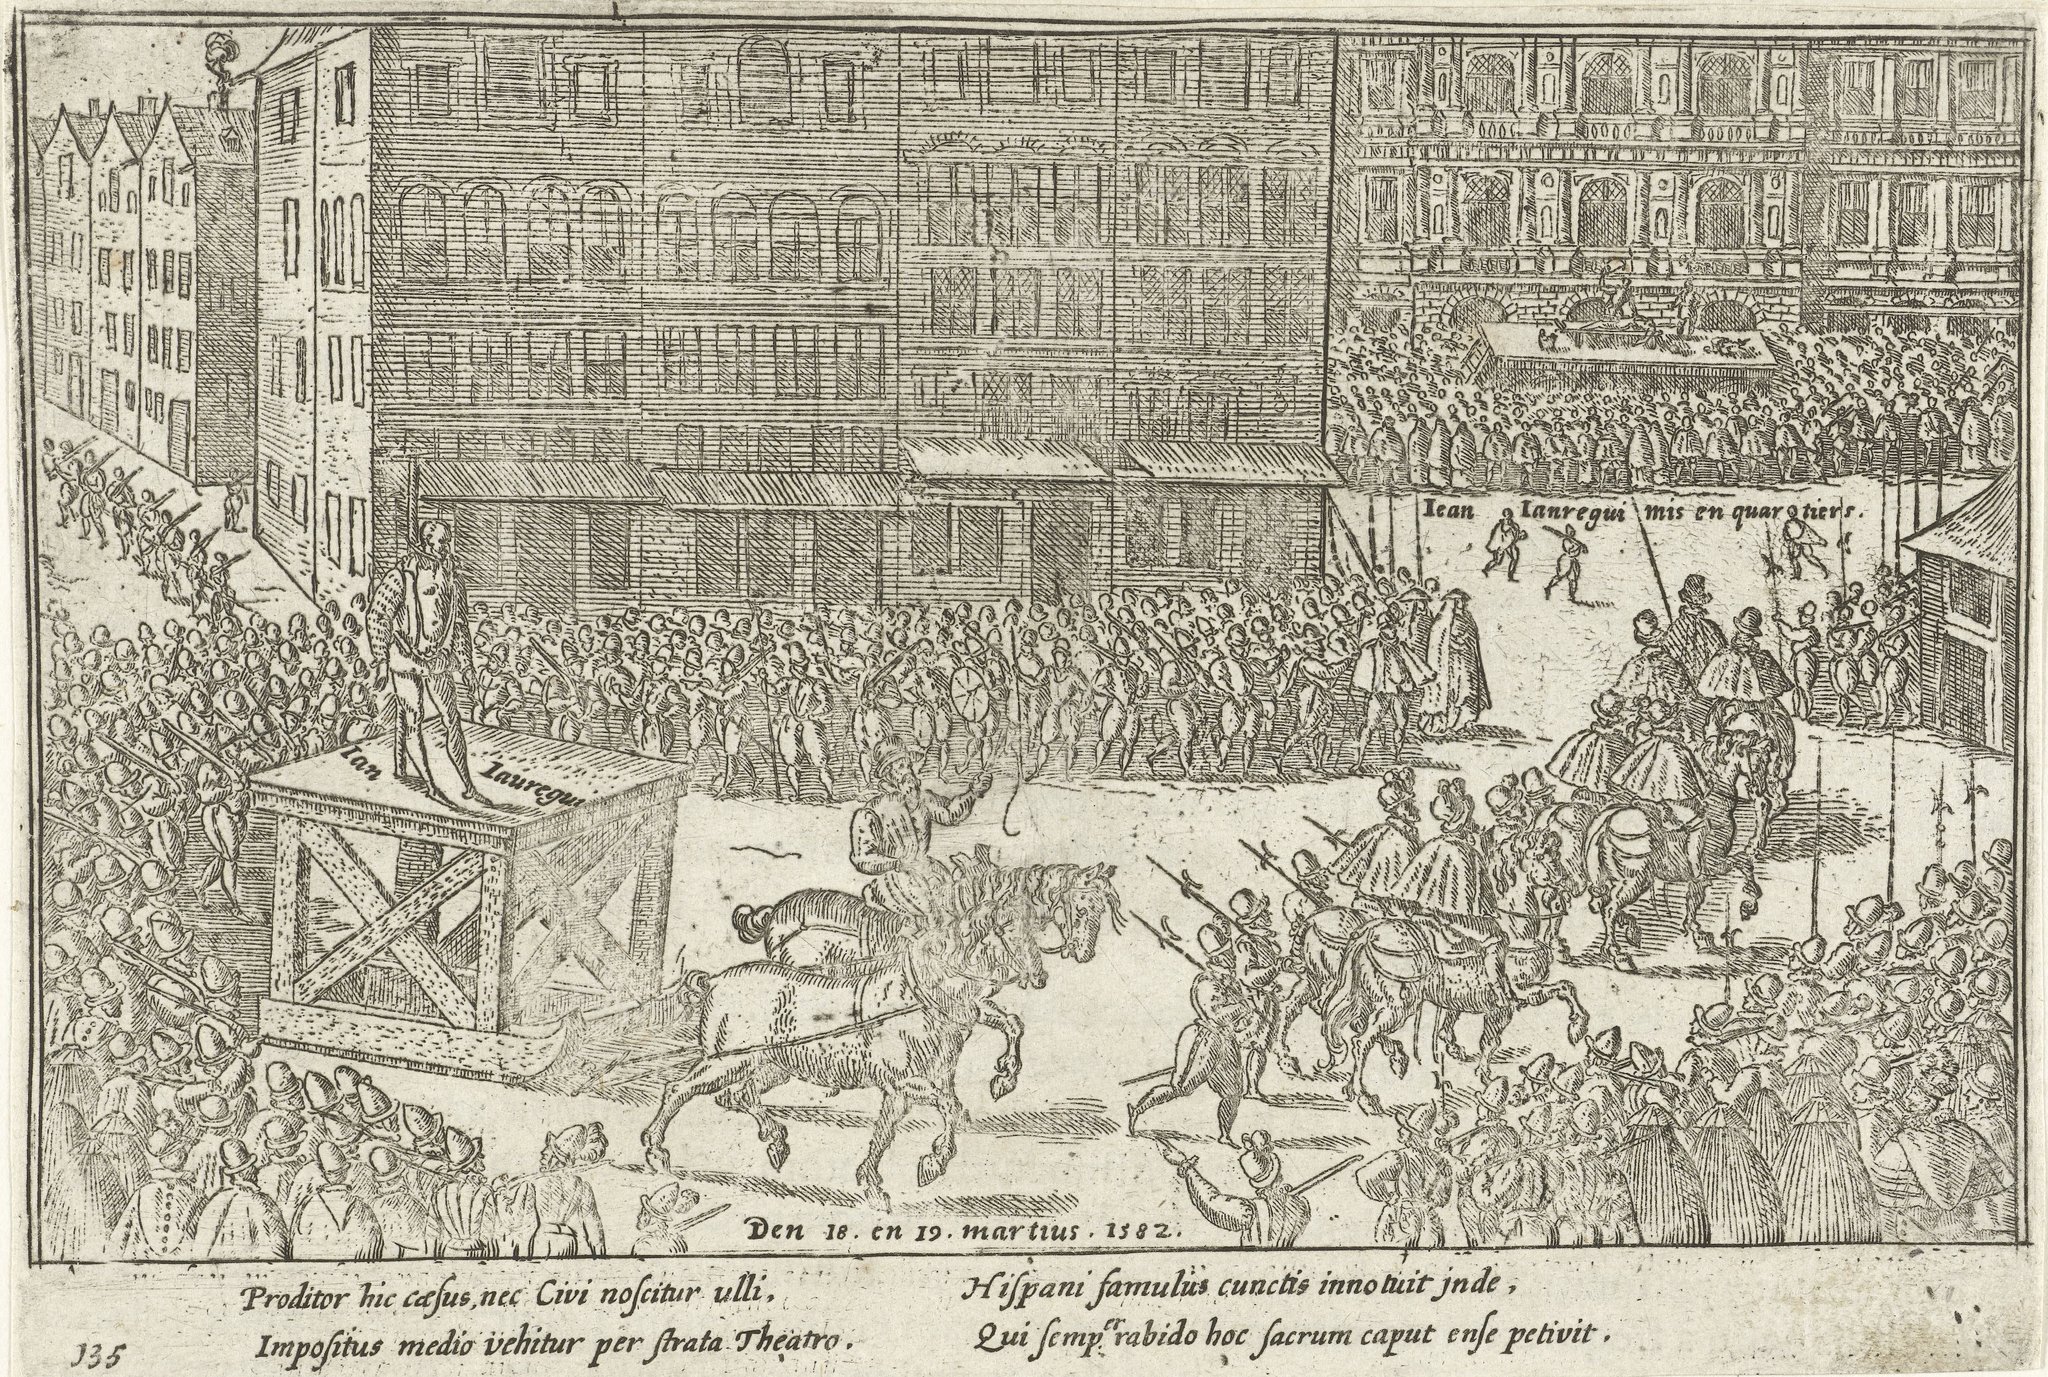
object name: history print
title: Rondrijden van het lichaam van Jean de Jauregui, 1582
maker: Anonymous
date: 1613-1615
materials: paper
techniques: etching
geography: northern netherlands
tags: mutilation of the corpse, body of the executed displayed in public, antwerp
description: Het rondrijden op een slede door de straten van Antwerpen van het tentoongestelde lichaam van Jean de Jauregui, de pleger van een mislukte aanslag op Willem van Oranje, op 18 en 19 maart 1582. Op de achtergrond wordt het lichaam in stukken gehakt. Met onderschrift van 4 regels in het Latijn. Genummerd 135. Bedrukt op achterzijde met tekst in het Latijn.